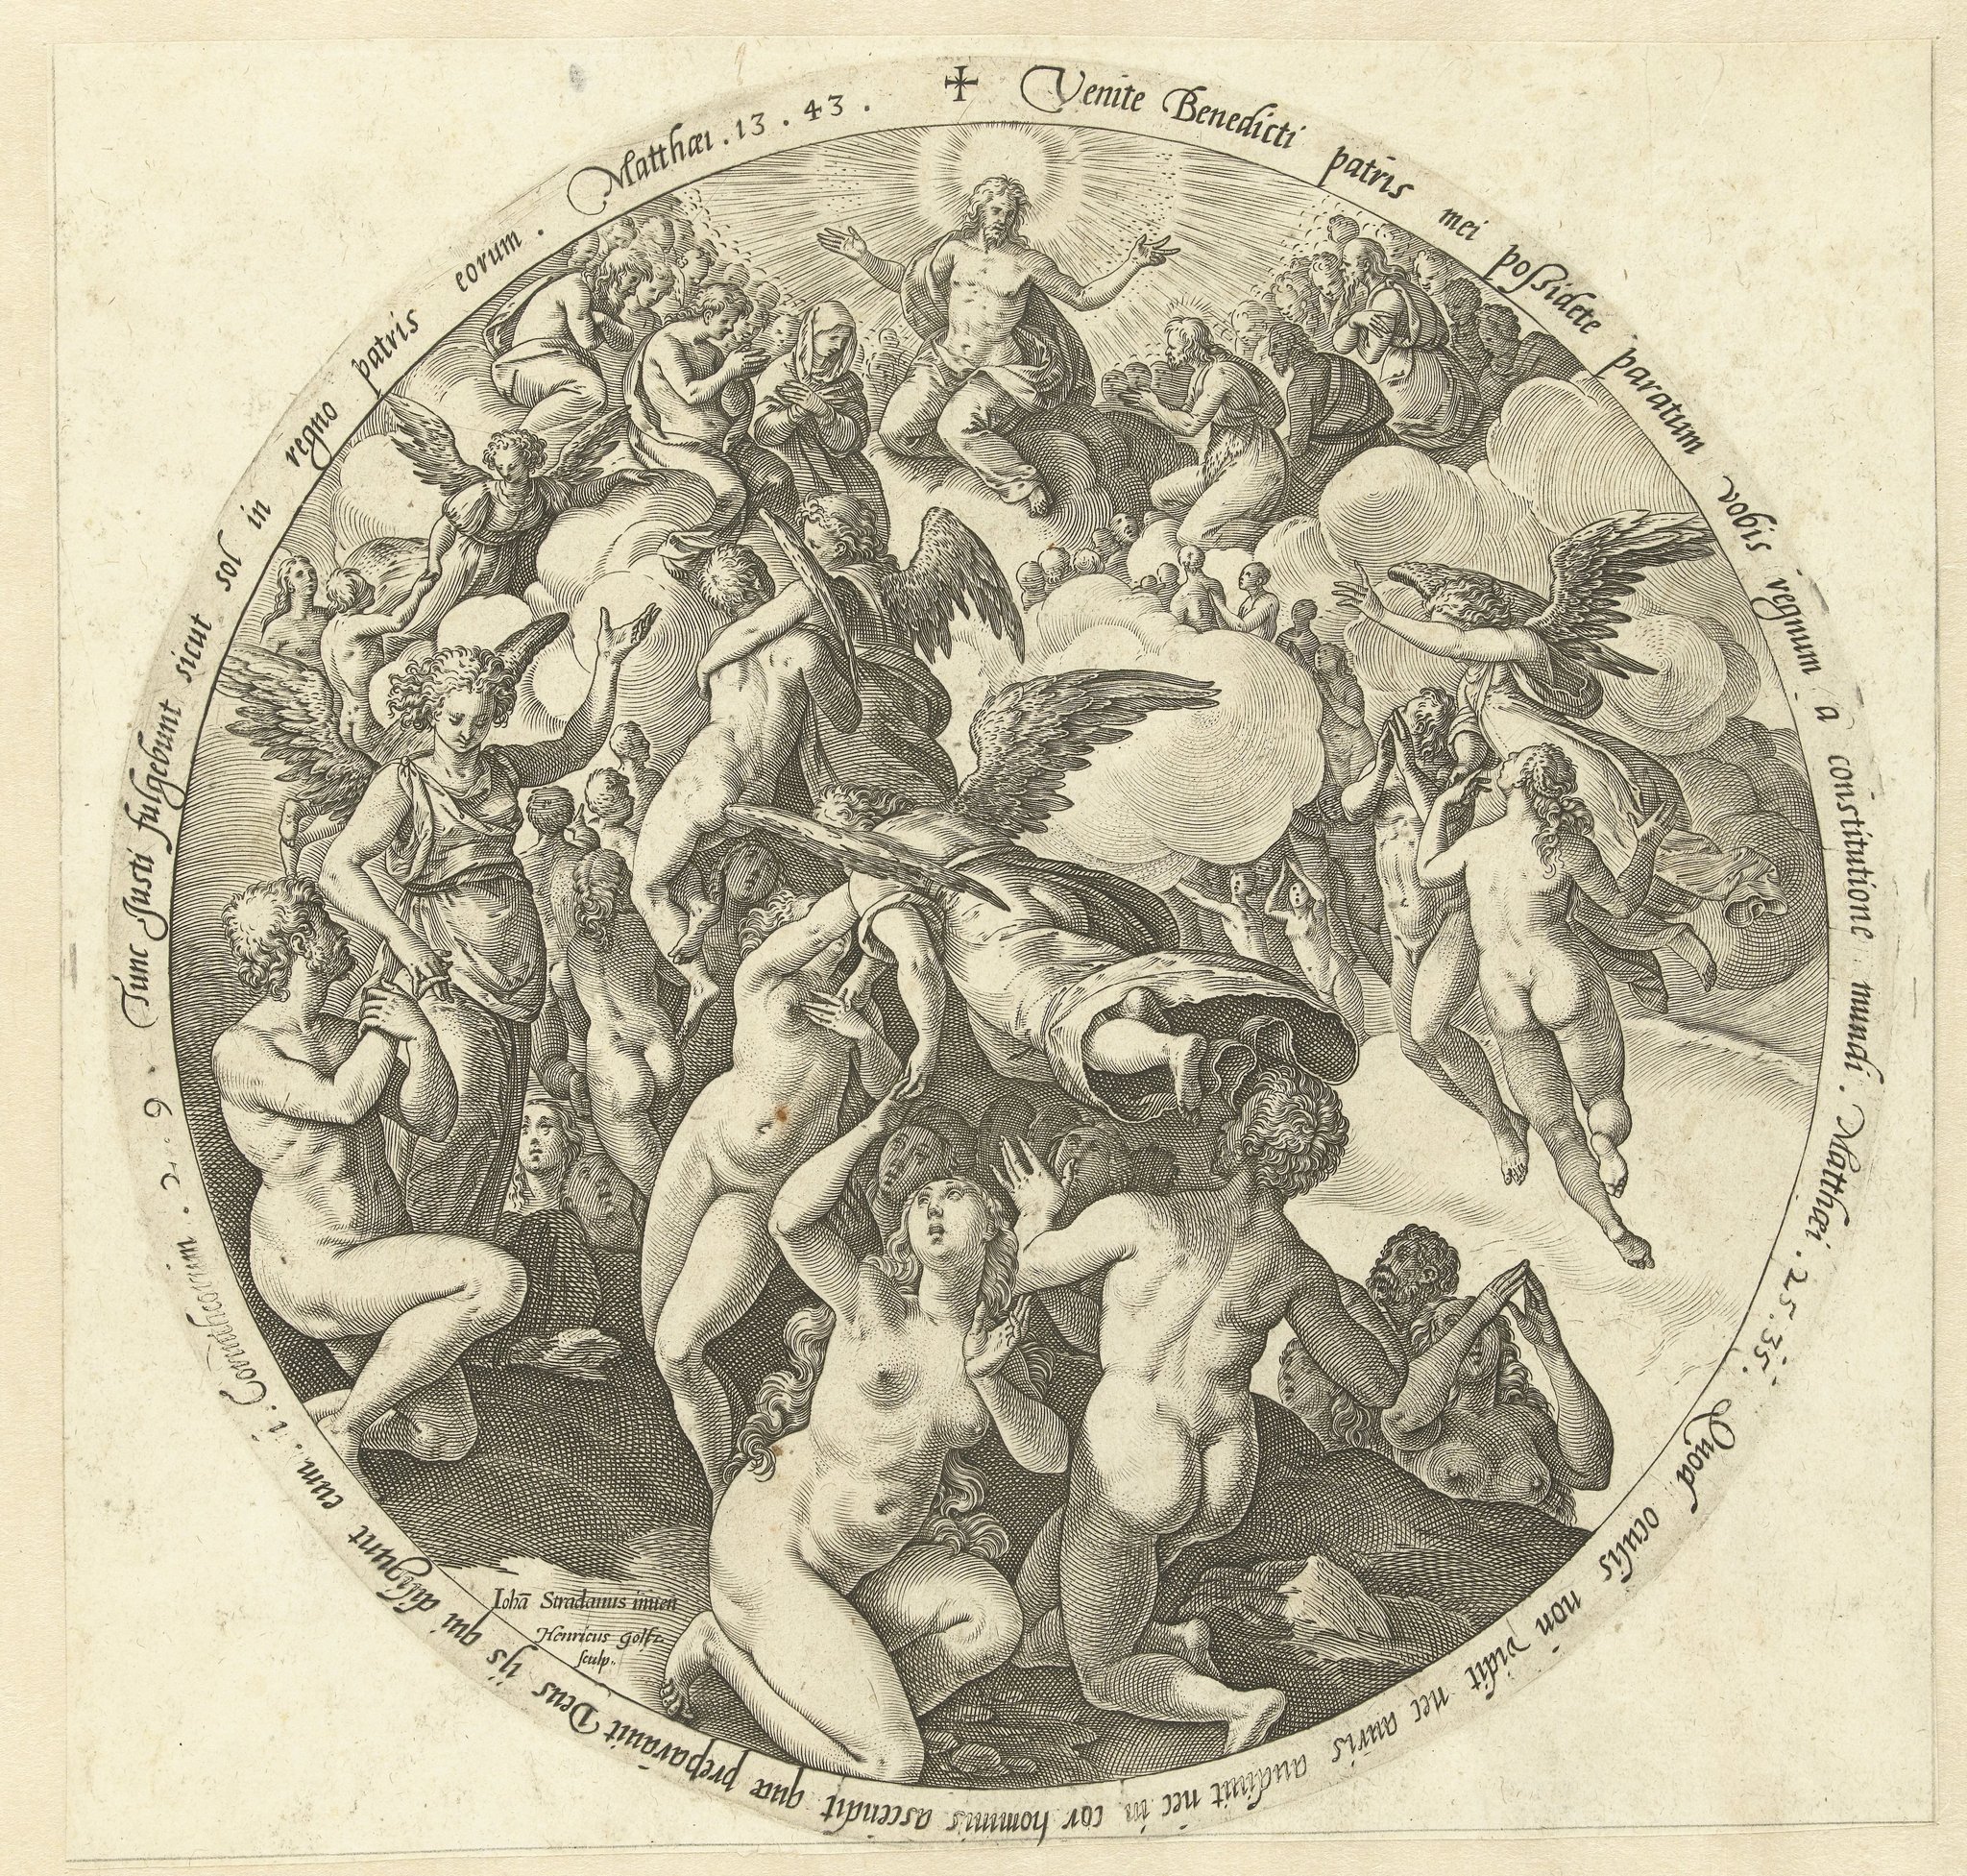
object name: print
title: De gezegenden worden ontvangen in de hemel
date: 1575-1579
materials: paper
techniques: engraving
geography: haarlem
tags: the blessed are brought to heaven ~ last judgement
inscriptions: collector's mark: Lugt 2228a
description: Ronde voorstelling van de aankomst van de gezegenden in de hemel. Engelen begeleiden de zielen naar boven, waar Christus troont temidden van een schare heiligen (onder wie Maria). Om de voorstelling bijbelteksten in het Latijn. Deze prent is onderdeel van een serie van vier ronde prenten met Laatste Oordeelscènes.